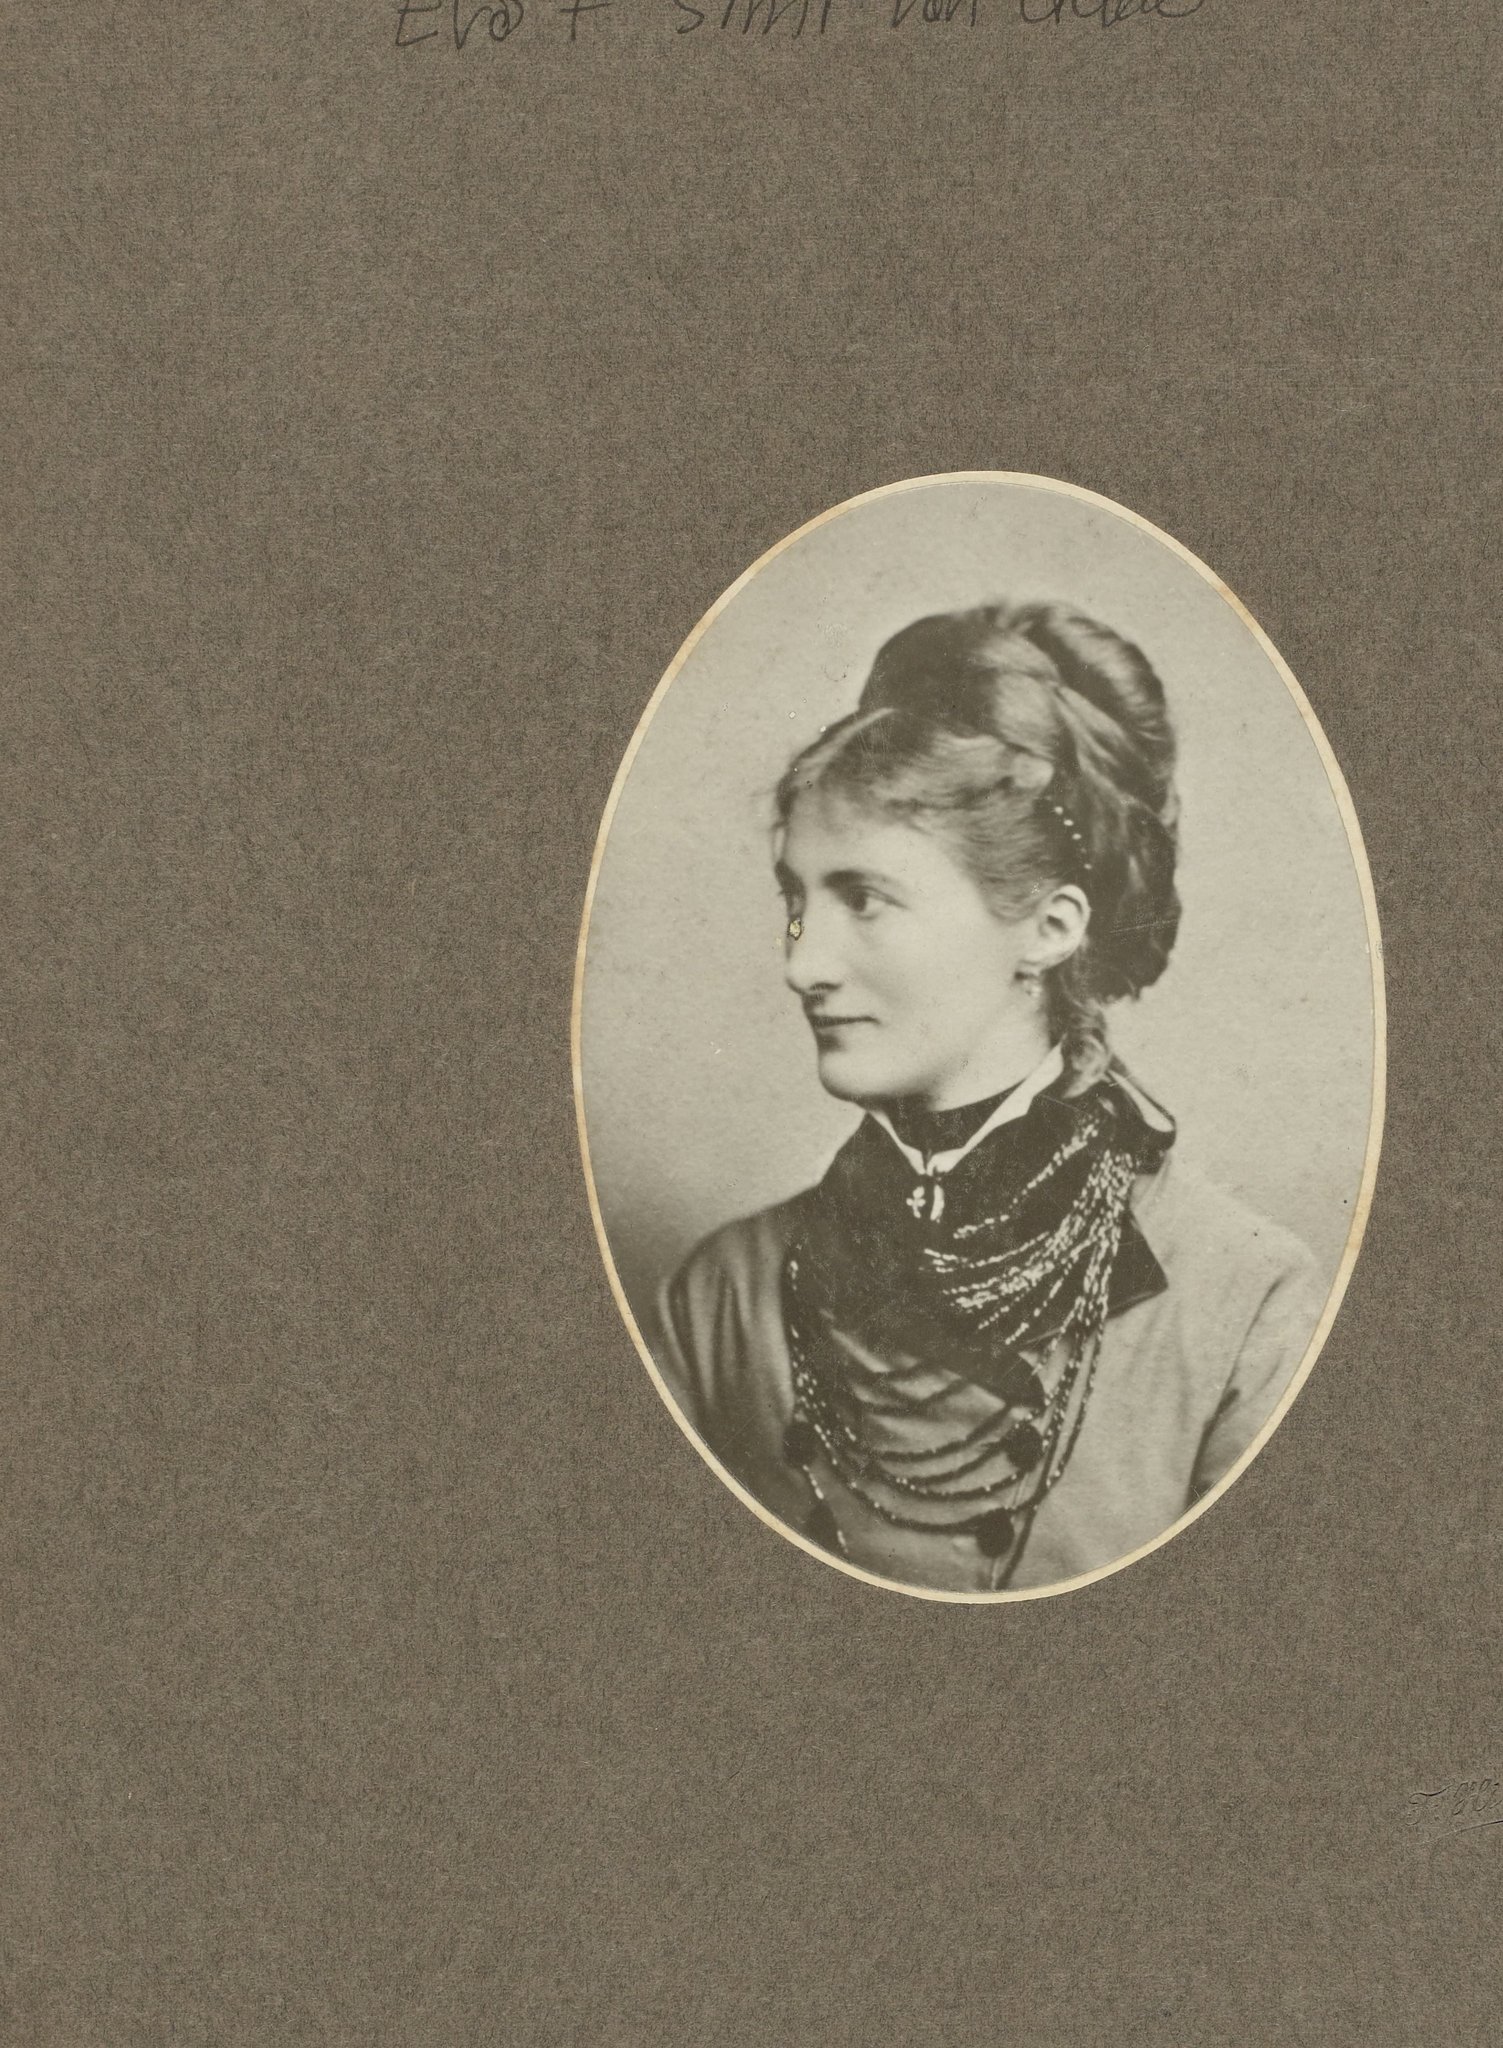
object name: photograph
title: Portret van Eva Boelen-Smidt van Gelder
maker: friedrich carel hisgen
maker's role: fotograaf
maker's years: 1846-1912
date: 1884-1890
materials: cardboard, photographic support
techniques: carbon print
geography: amsterdam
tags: historical persons - bb - woman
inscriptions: signature: ‘F. Hisgen’, inscription: ‘Eva Boelen Smidt van Gelder’